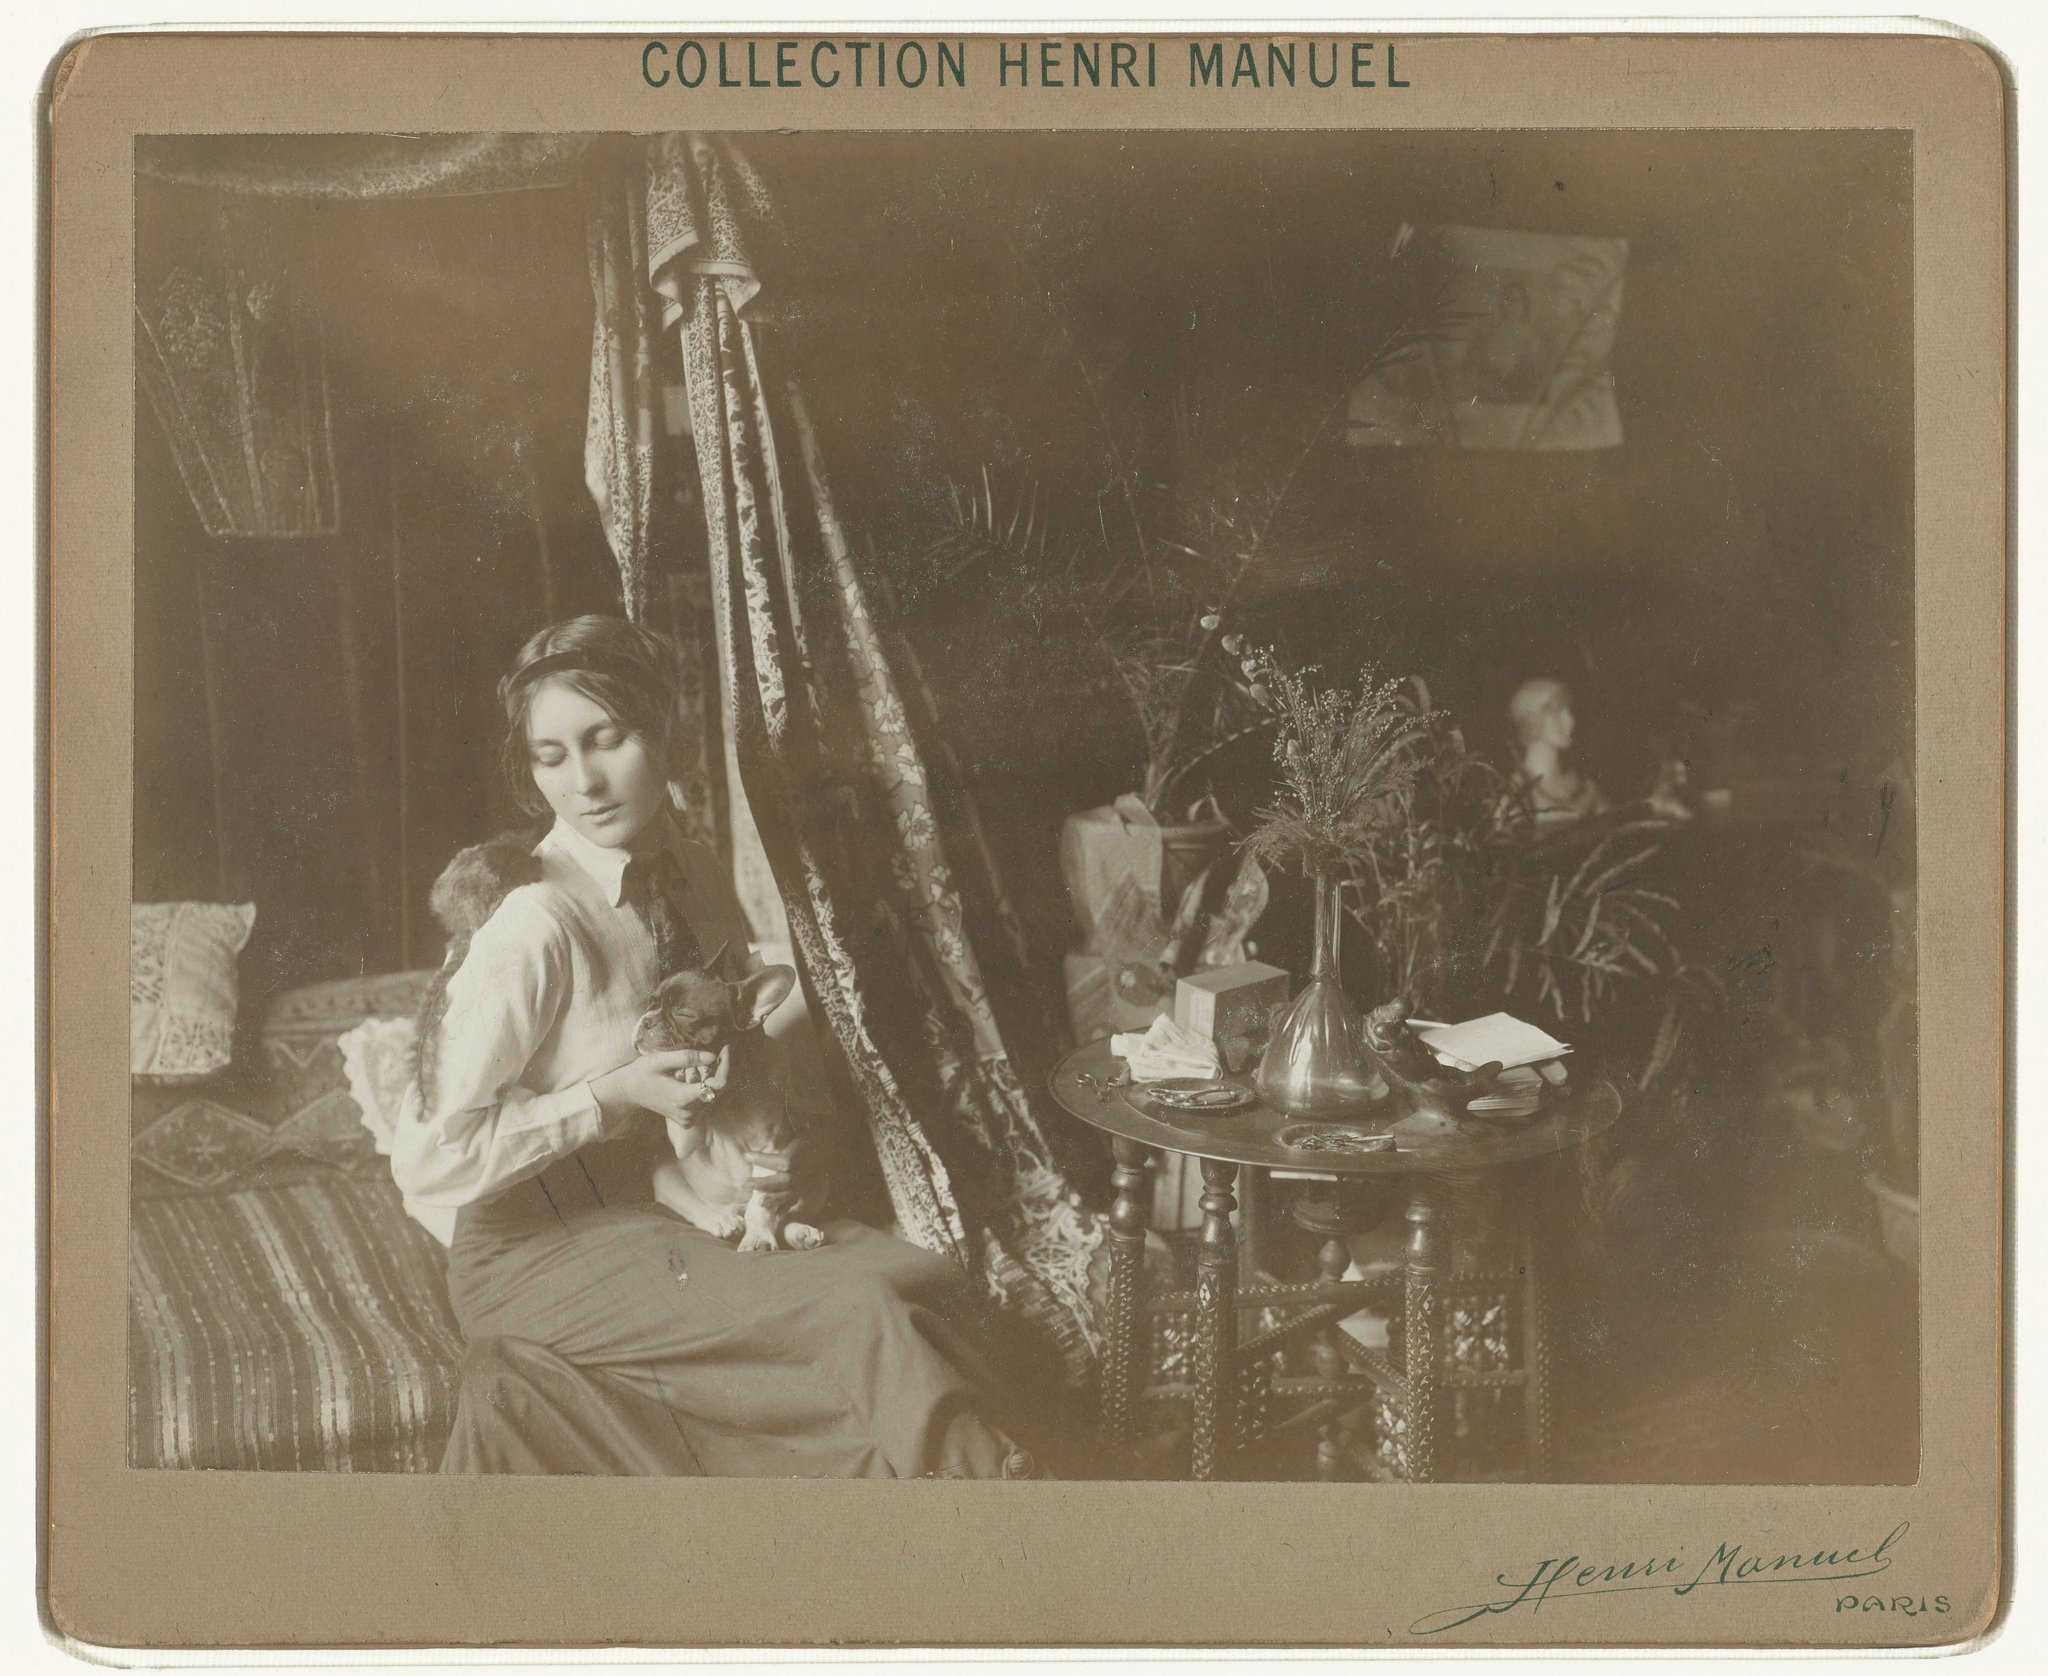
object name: photograph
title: Napierkowska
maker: henri manuel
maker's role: fotograaf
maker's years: 1874-1947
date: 1925-1930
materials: paper, cardboard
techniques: gelatin silver print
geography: paris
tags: paris, portrait of actor, actress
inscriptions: address: ‘Henri/ MANUEL/ EXPERT/ Photographe d'Art/ 27. Rue du Faubg Montmartre/ Paris/ Téléphone/ No 318.39’